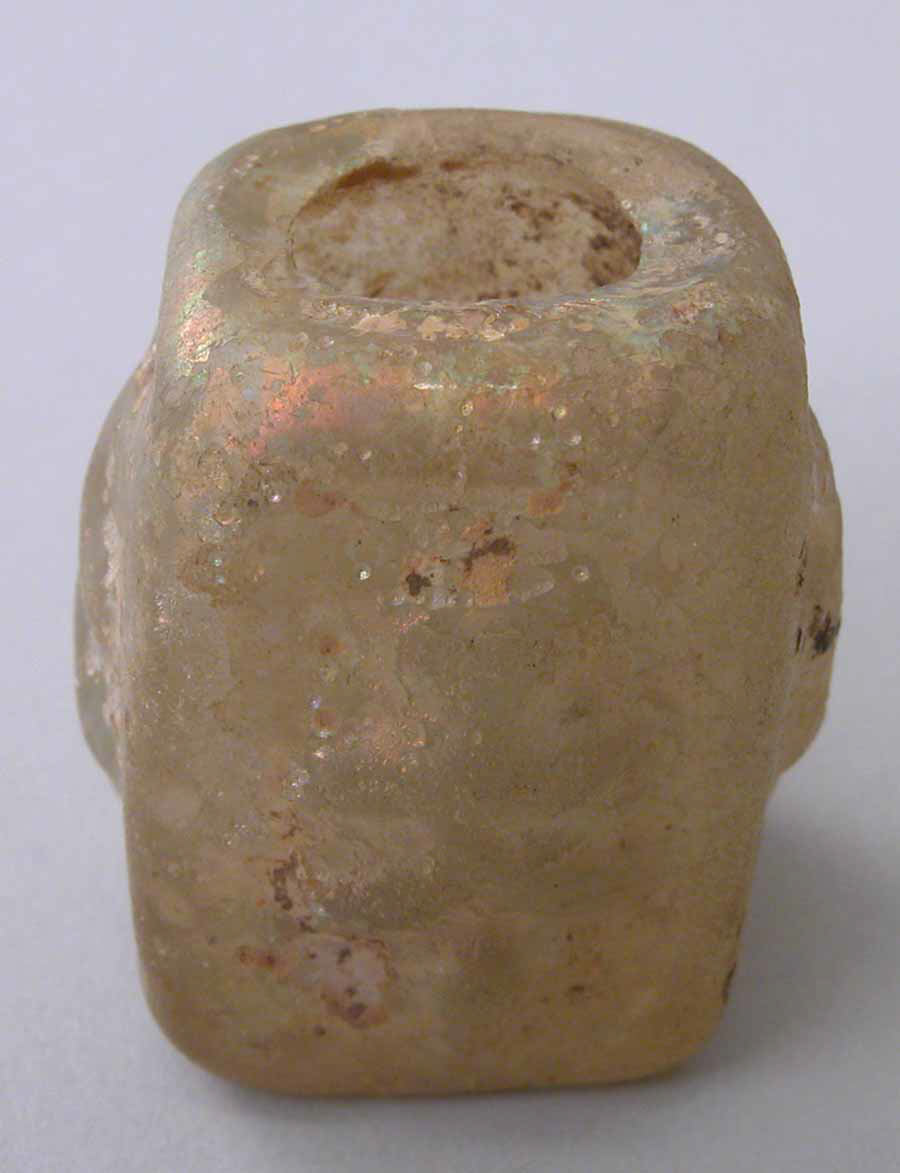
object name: bottle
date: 801-1100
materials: glass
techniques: glassblowing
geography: egypt